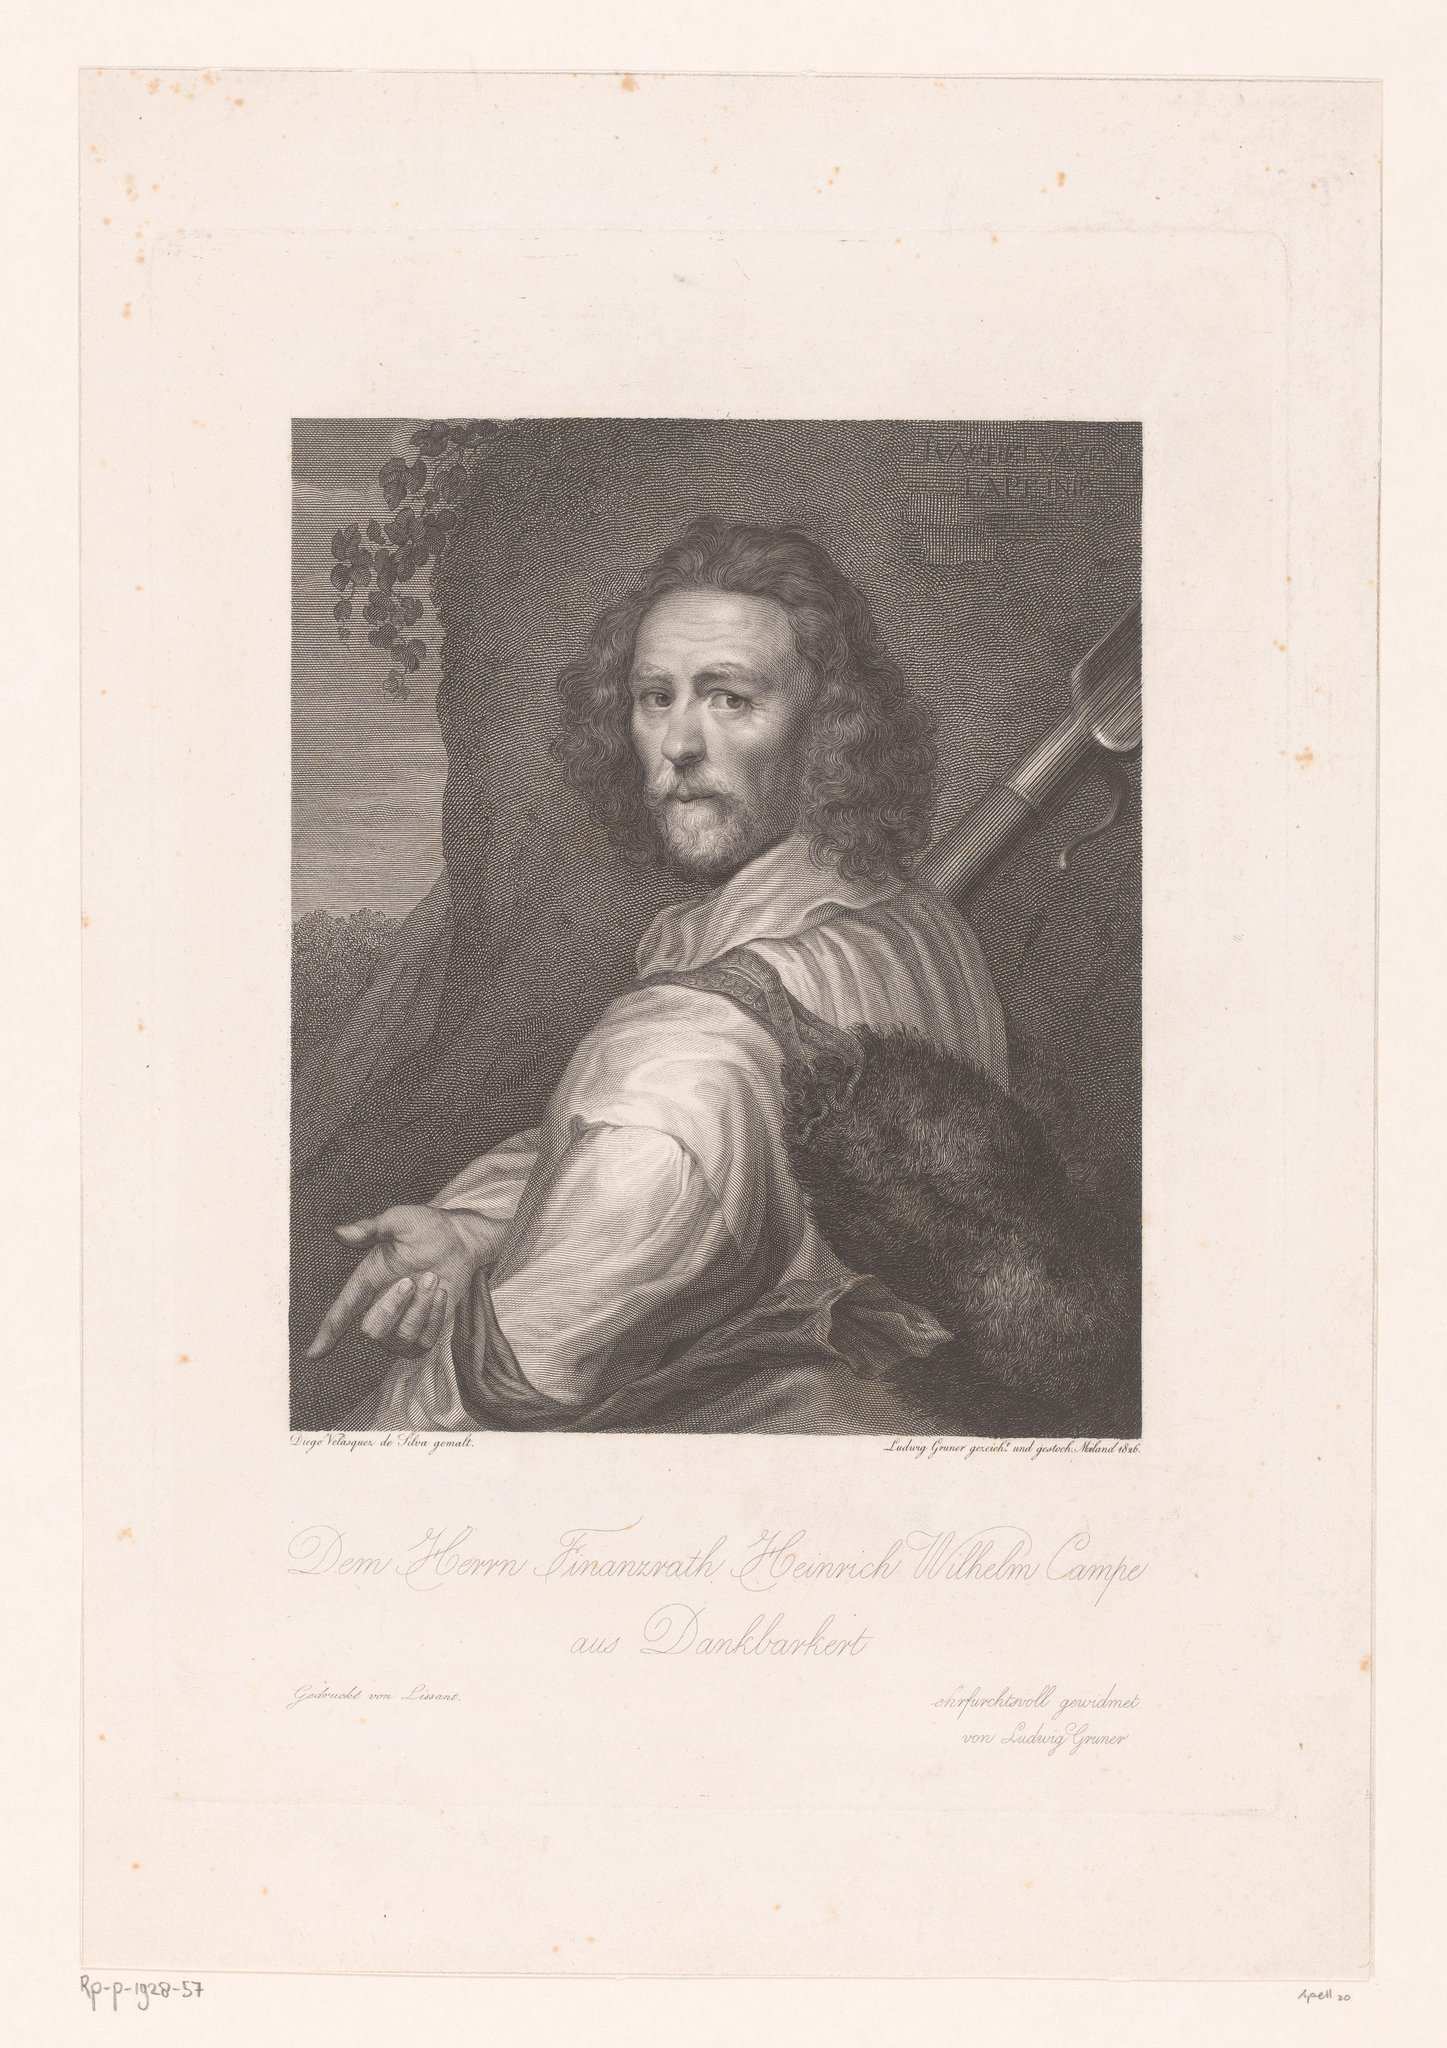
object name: print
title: Portret van Heinrich Wilhelm Campe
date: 1811-1882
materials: paper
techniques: engraving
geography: milan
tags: historical persons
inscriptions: collector's mark: Lugt 2228